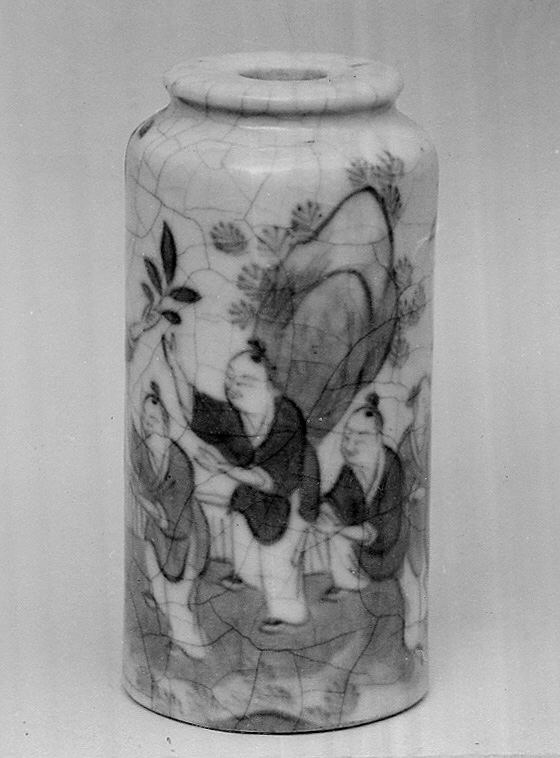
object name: snuff bottle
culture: chinese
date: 1736-1795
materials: paste, porcelain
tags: men